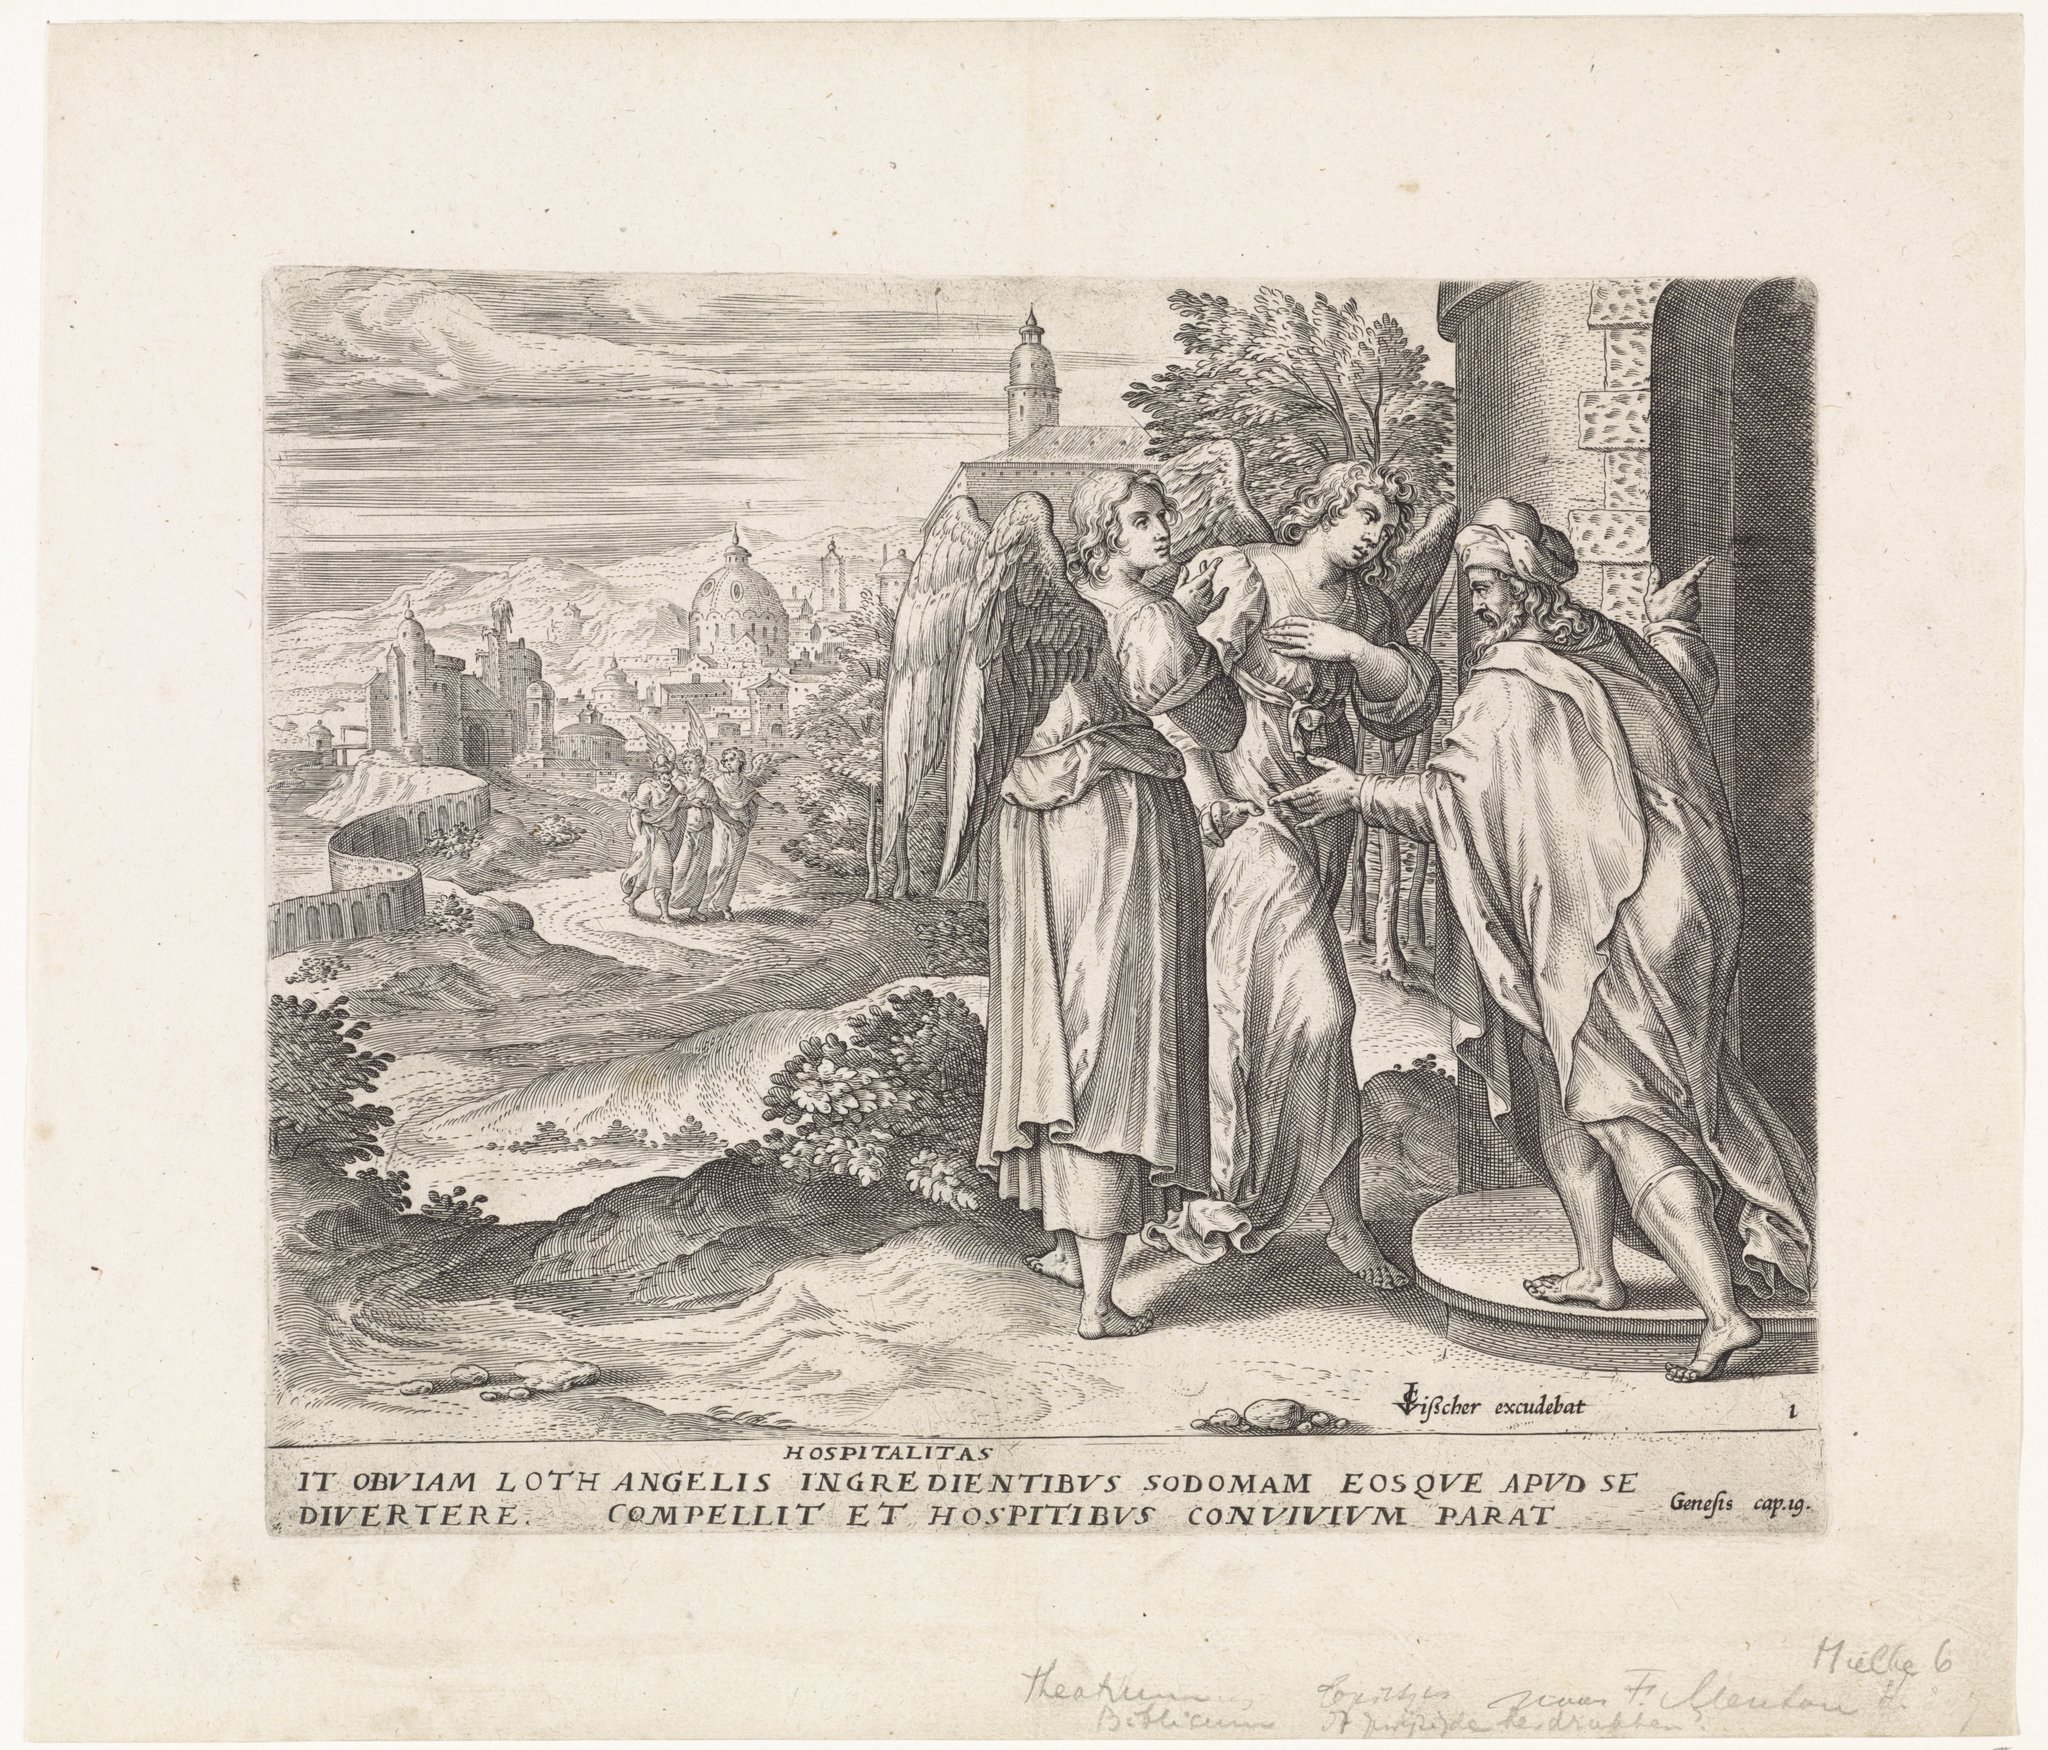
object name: print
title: Theatrum biblicum (...)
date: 1579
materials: paper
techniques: engraving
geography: amsterdam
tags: lot and the two angels (genesis 19:1-23)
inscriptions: collector's mark: Lugt 2228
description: Deze staat wordt niet beschreven in The New Hollstein. De prent mist het seriemerk g linksboven, maar is wel uitgegeven door Claes Jansz. Visscher (II). Latere staat van prent gebruikt in: Theatrum biblicum : hoc est historiae sacrae veteris et novi testamenti tabulis aeneis expressae. Opus praesentatissimorum huius ac superioris seculi pictorum atque sculptorum, summo studio conquisitum et in lucem editum. Amsterdam: Claes Jansz. Visscher, 1643.